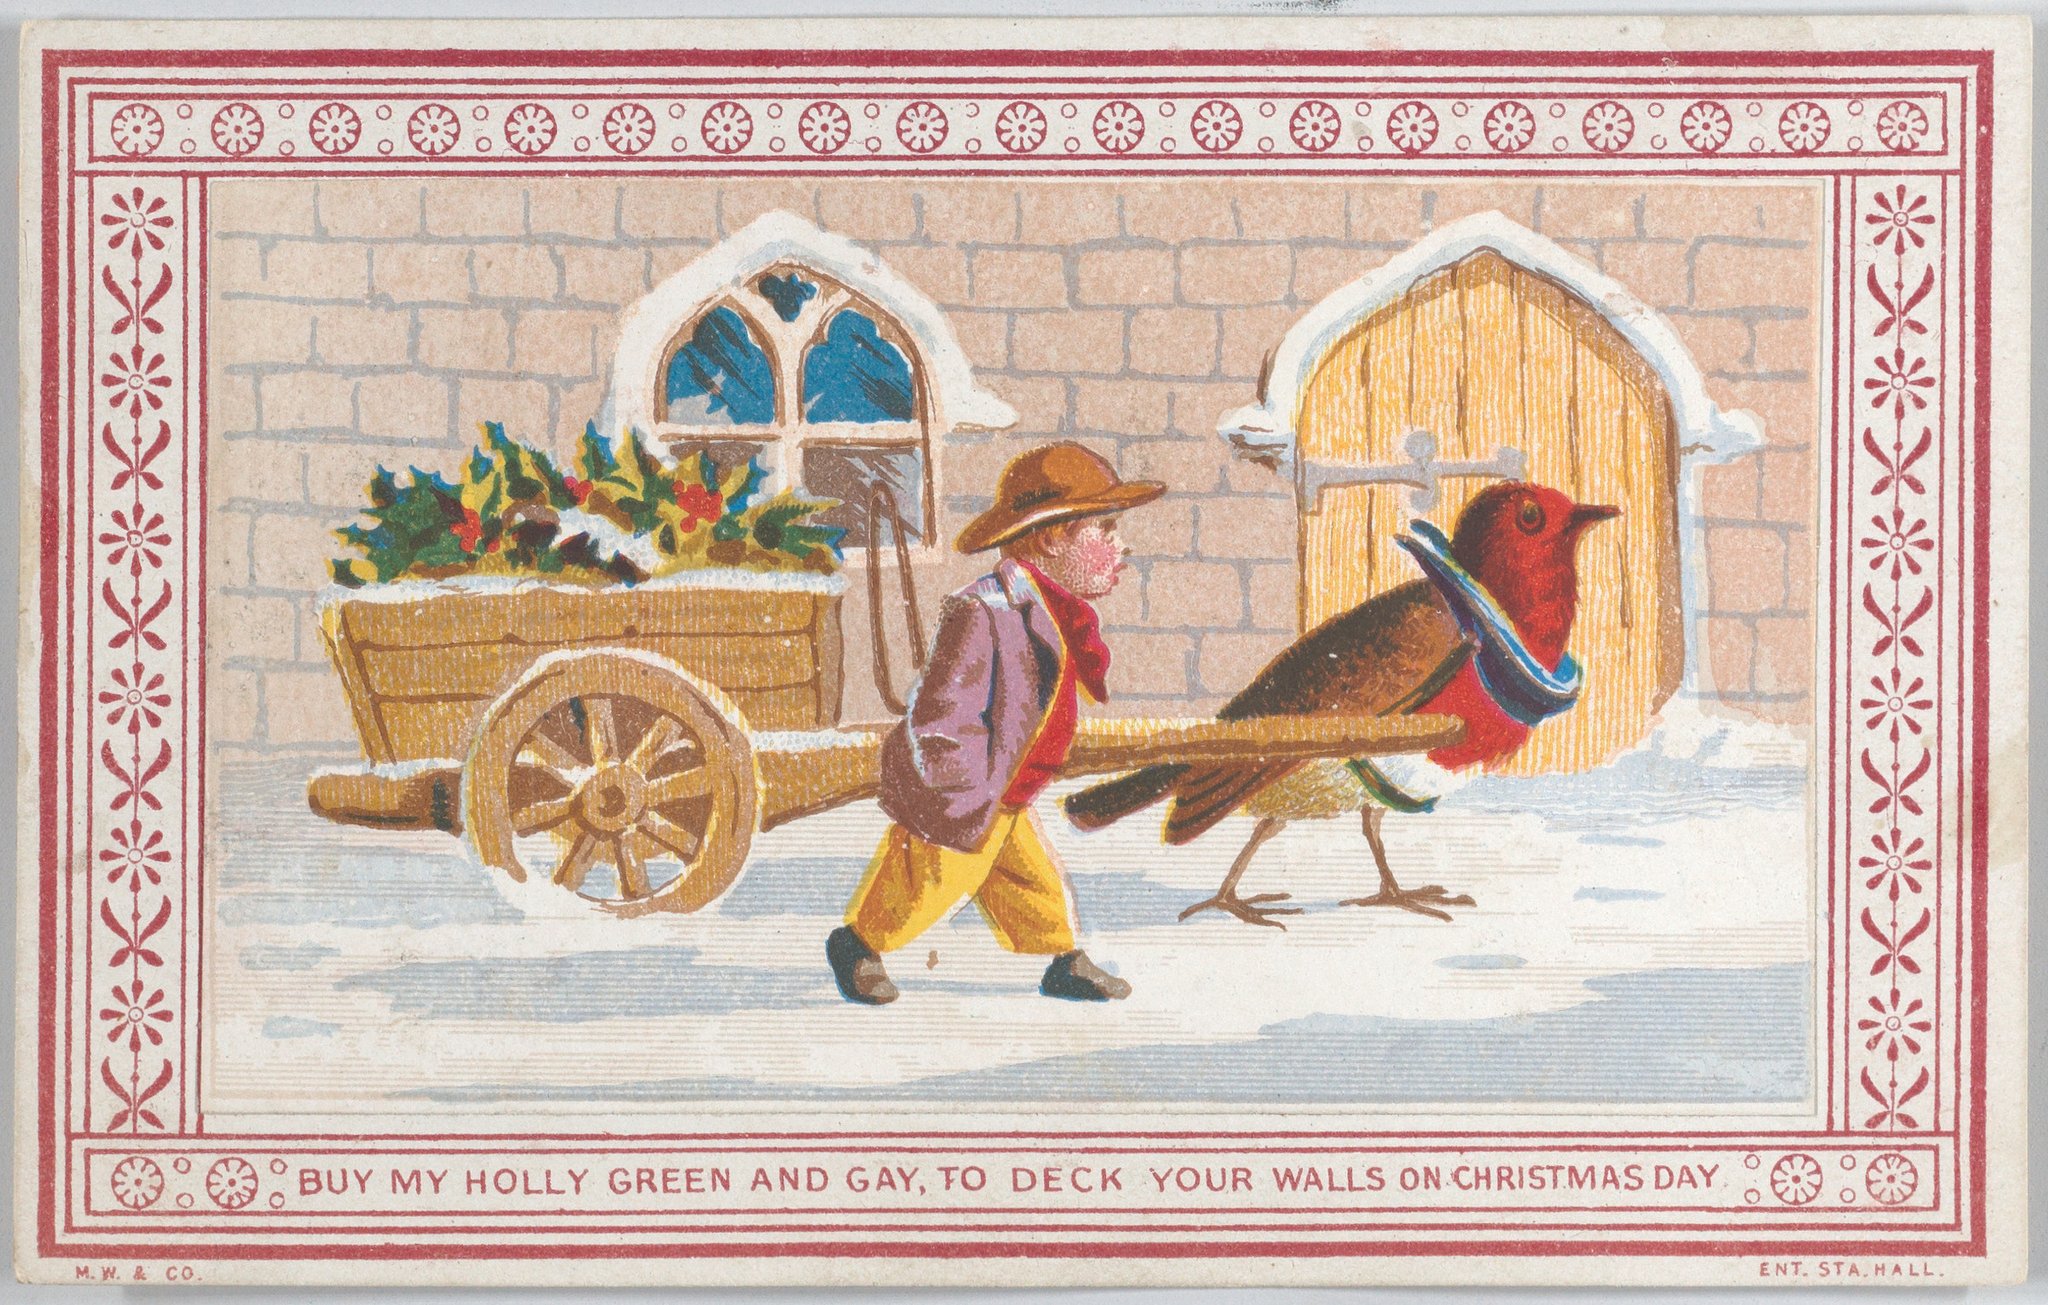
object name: valentine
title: Christmas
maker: Anonymous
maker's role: artist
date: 1874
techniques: chromolithography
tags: birds,men,christmas,carts